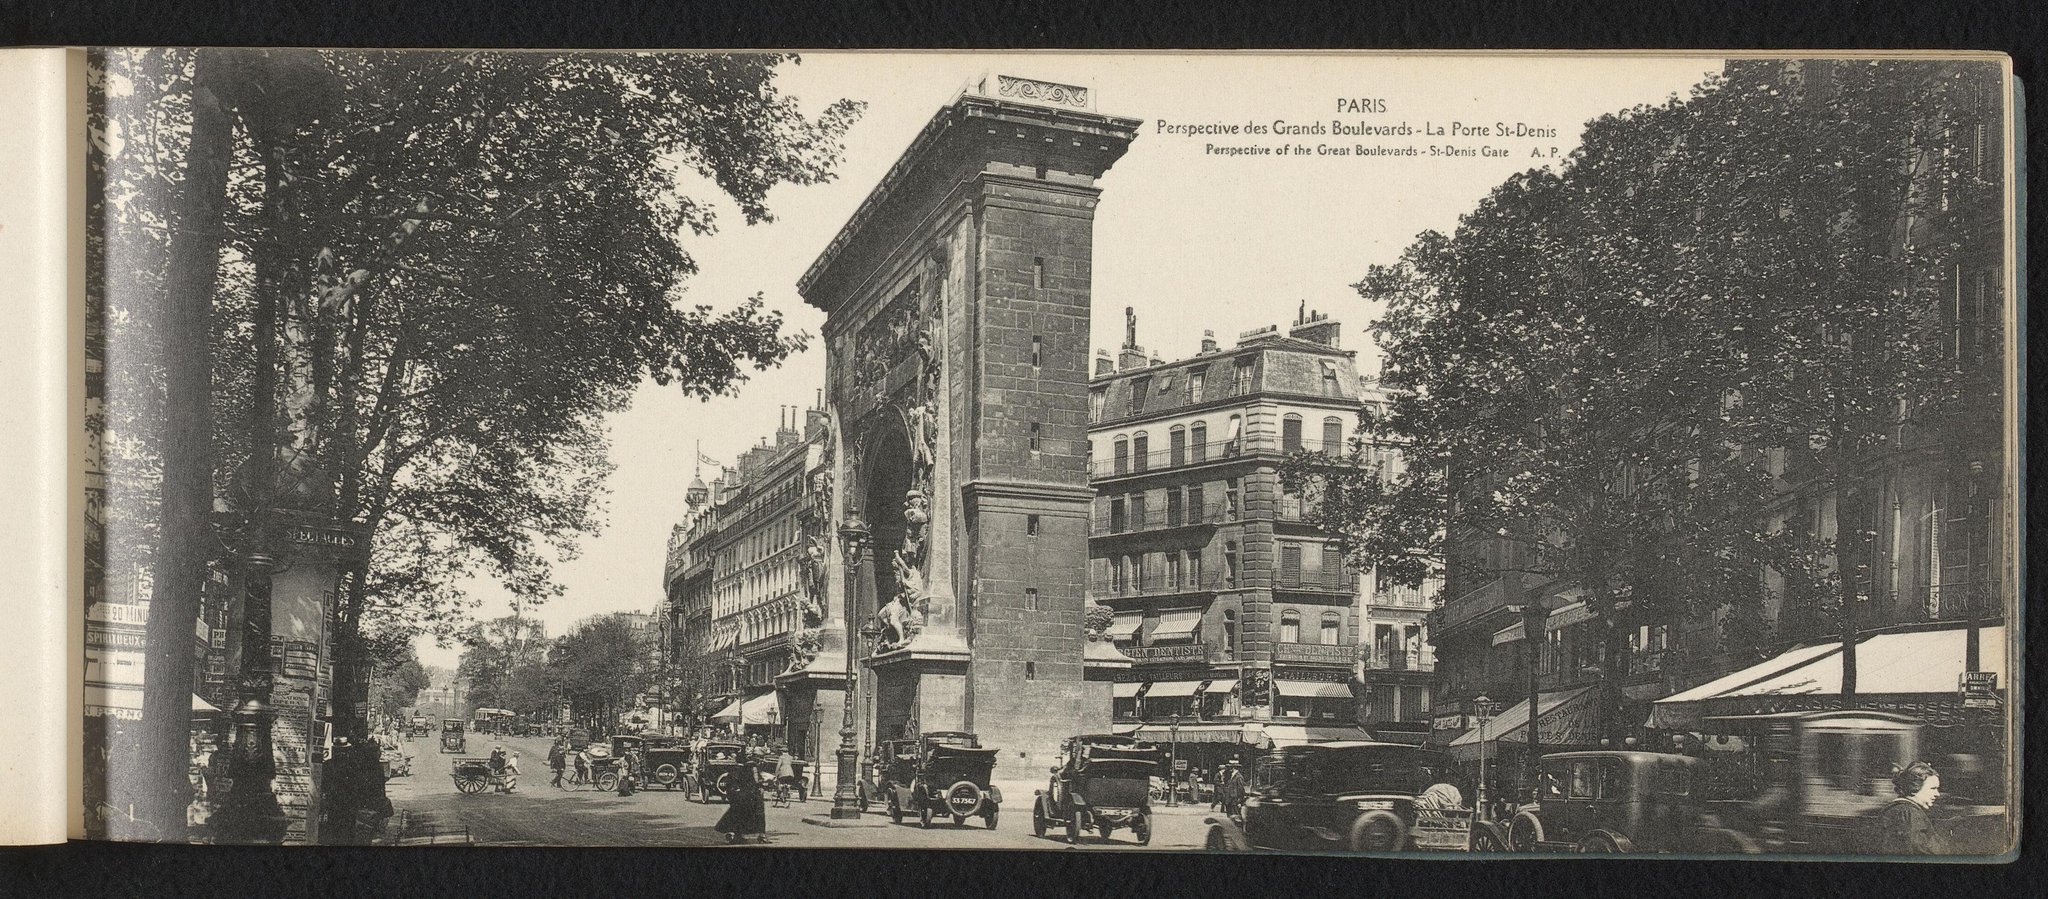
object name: photomechanical print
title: Paris. Perspective des Grands Boulevards. La Porte St. Denis / Perspective of the Great Boulevards. St. Denis Gate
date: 1910-1925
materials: cardboard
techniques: photograph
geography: paris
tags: avenue, boulevard, promenade, esplanade (+ city(-scape) with figures, staffage), city-gate (+ city(-scape) with figures, staffage)